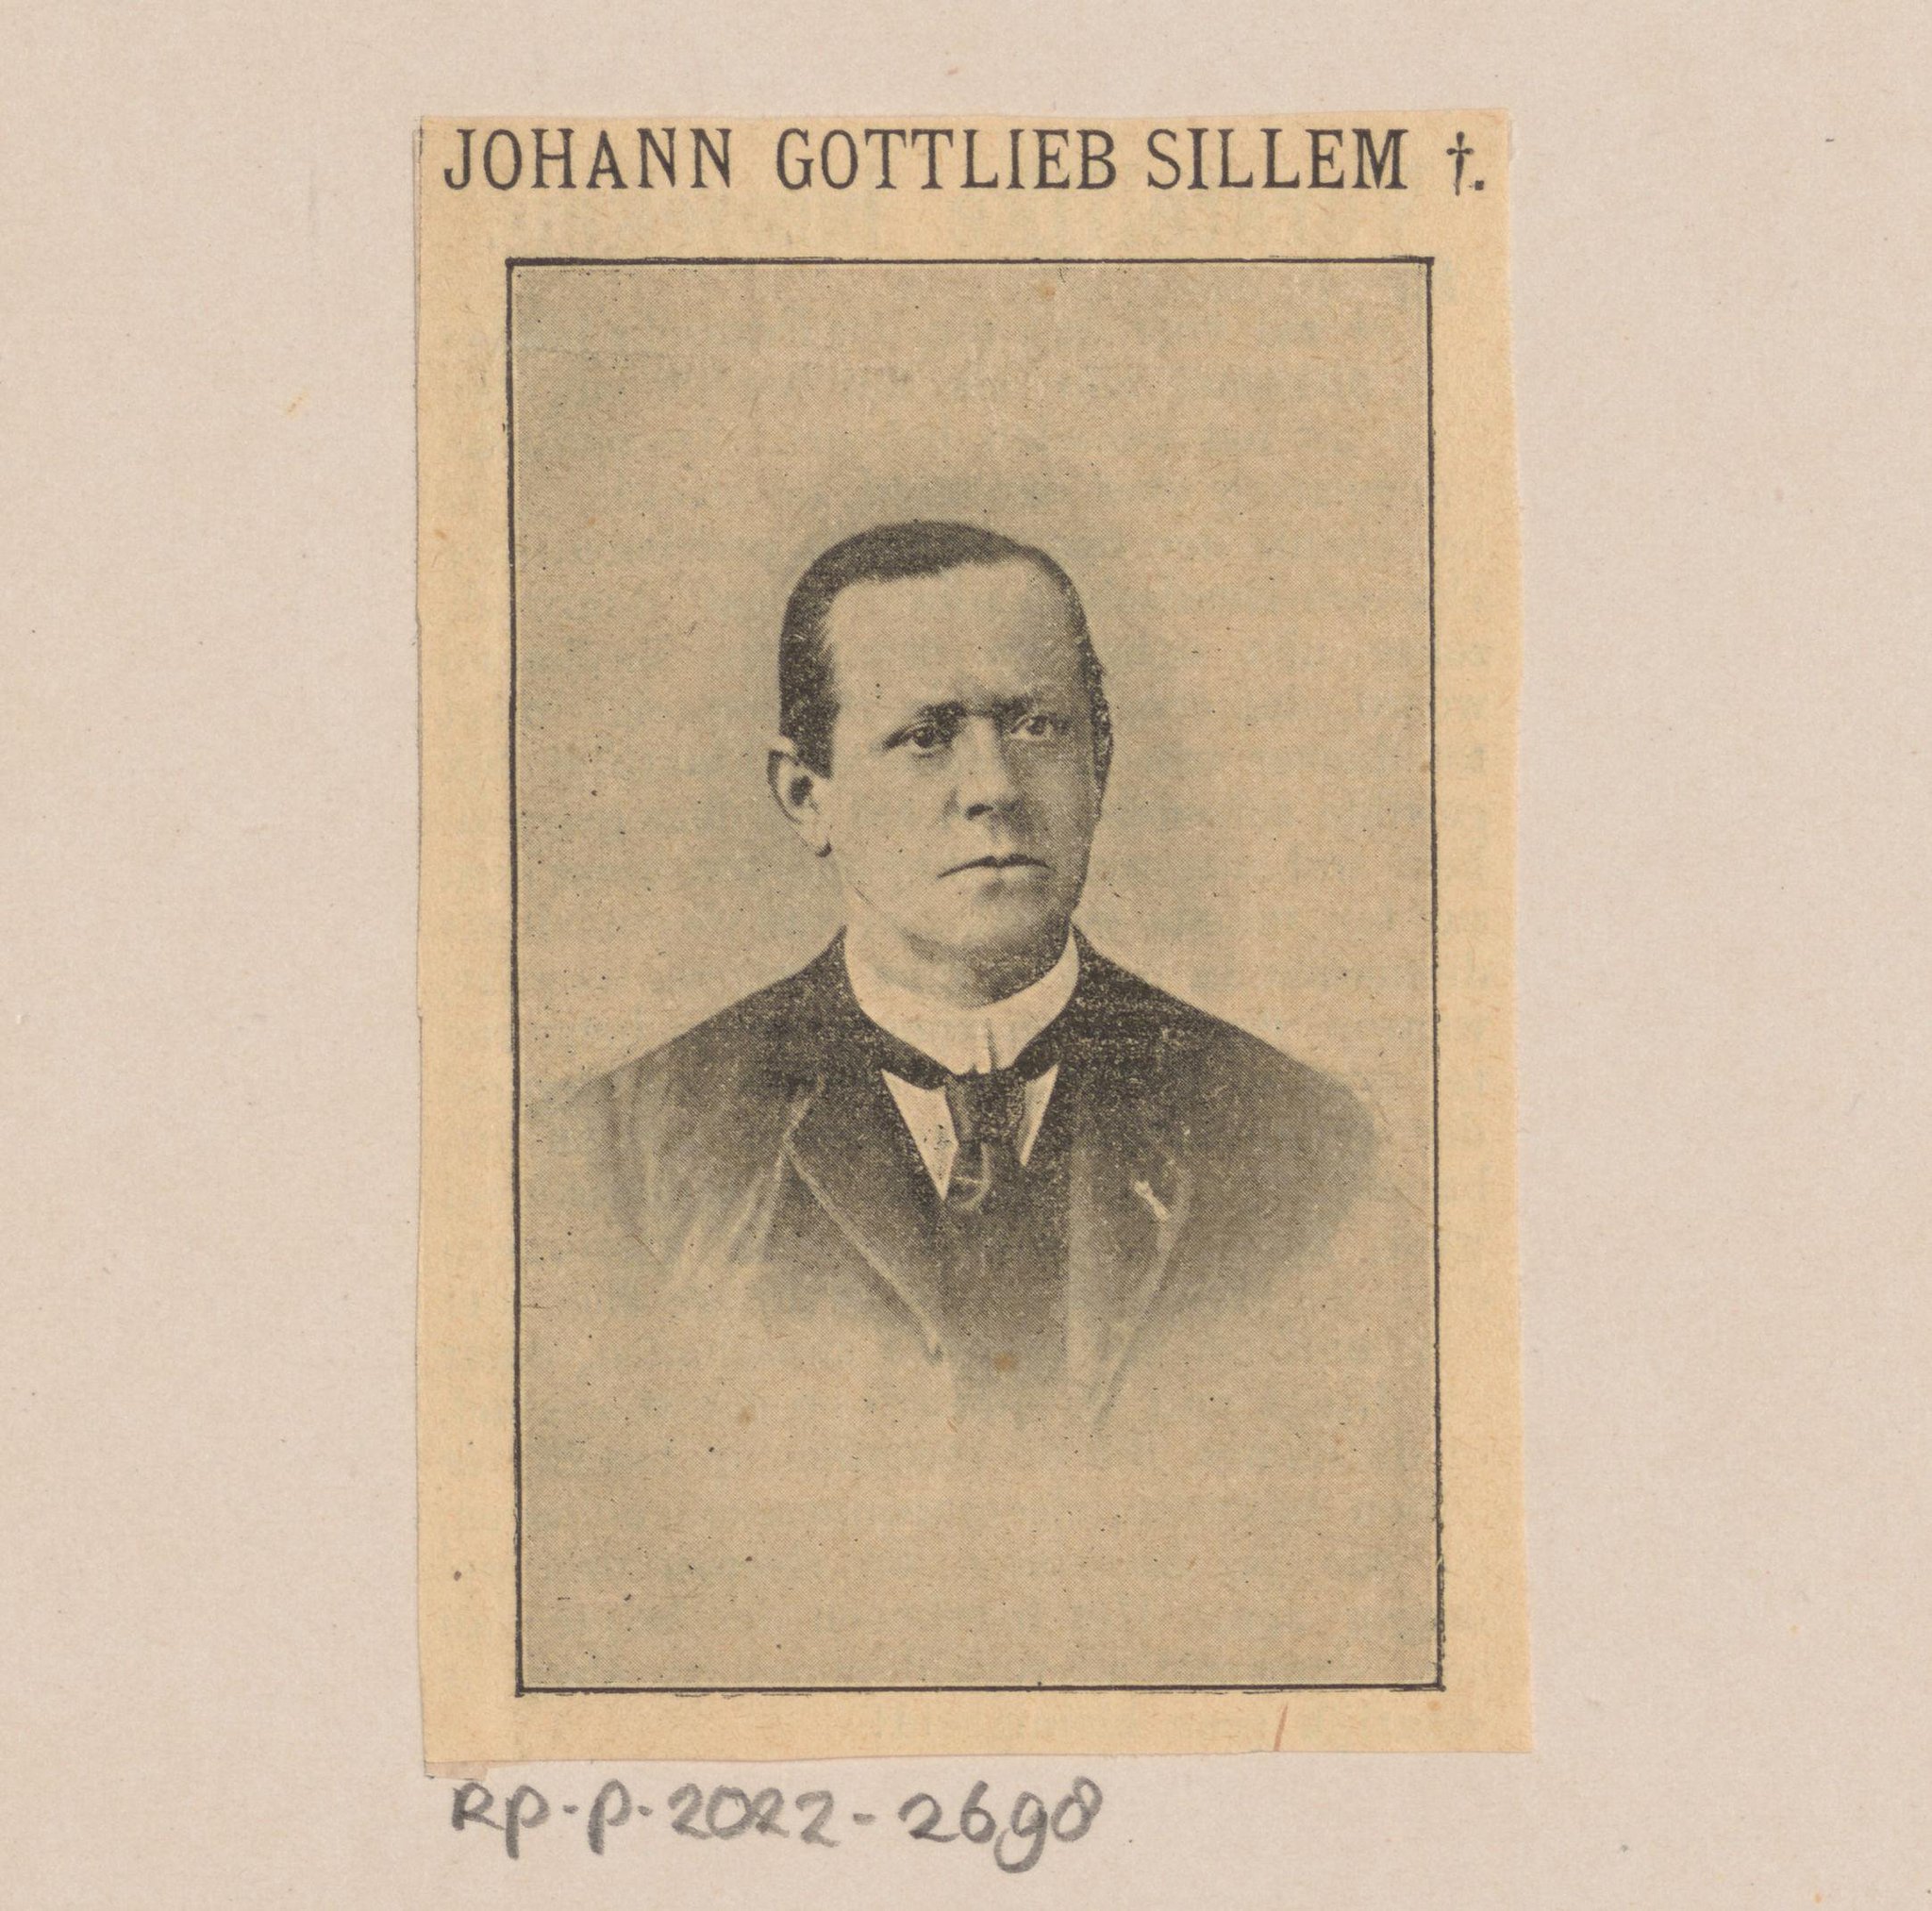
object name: photomechanical print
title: Portret van John Sillem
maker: Anonymous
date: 1882-1970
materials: paper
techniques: letterpress printing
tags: amsterdam, banker, historical persons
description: Fotomechanische afdruk uit een onbekende publicatie.